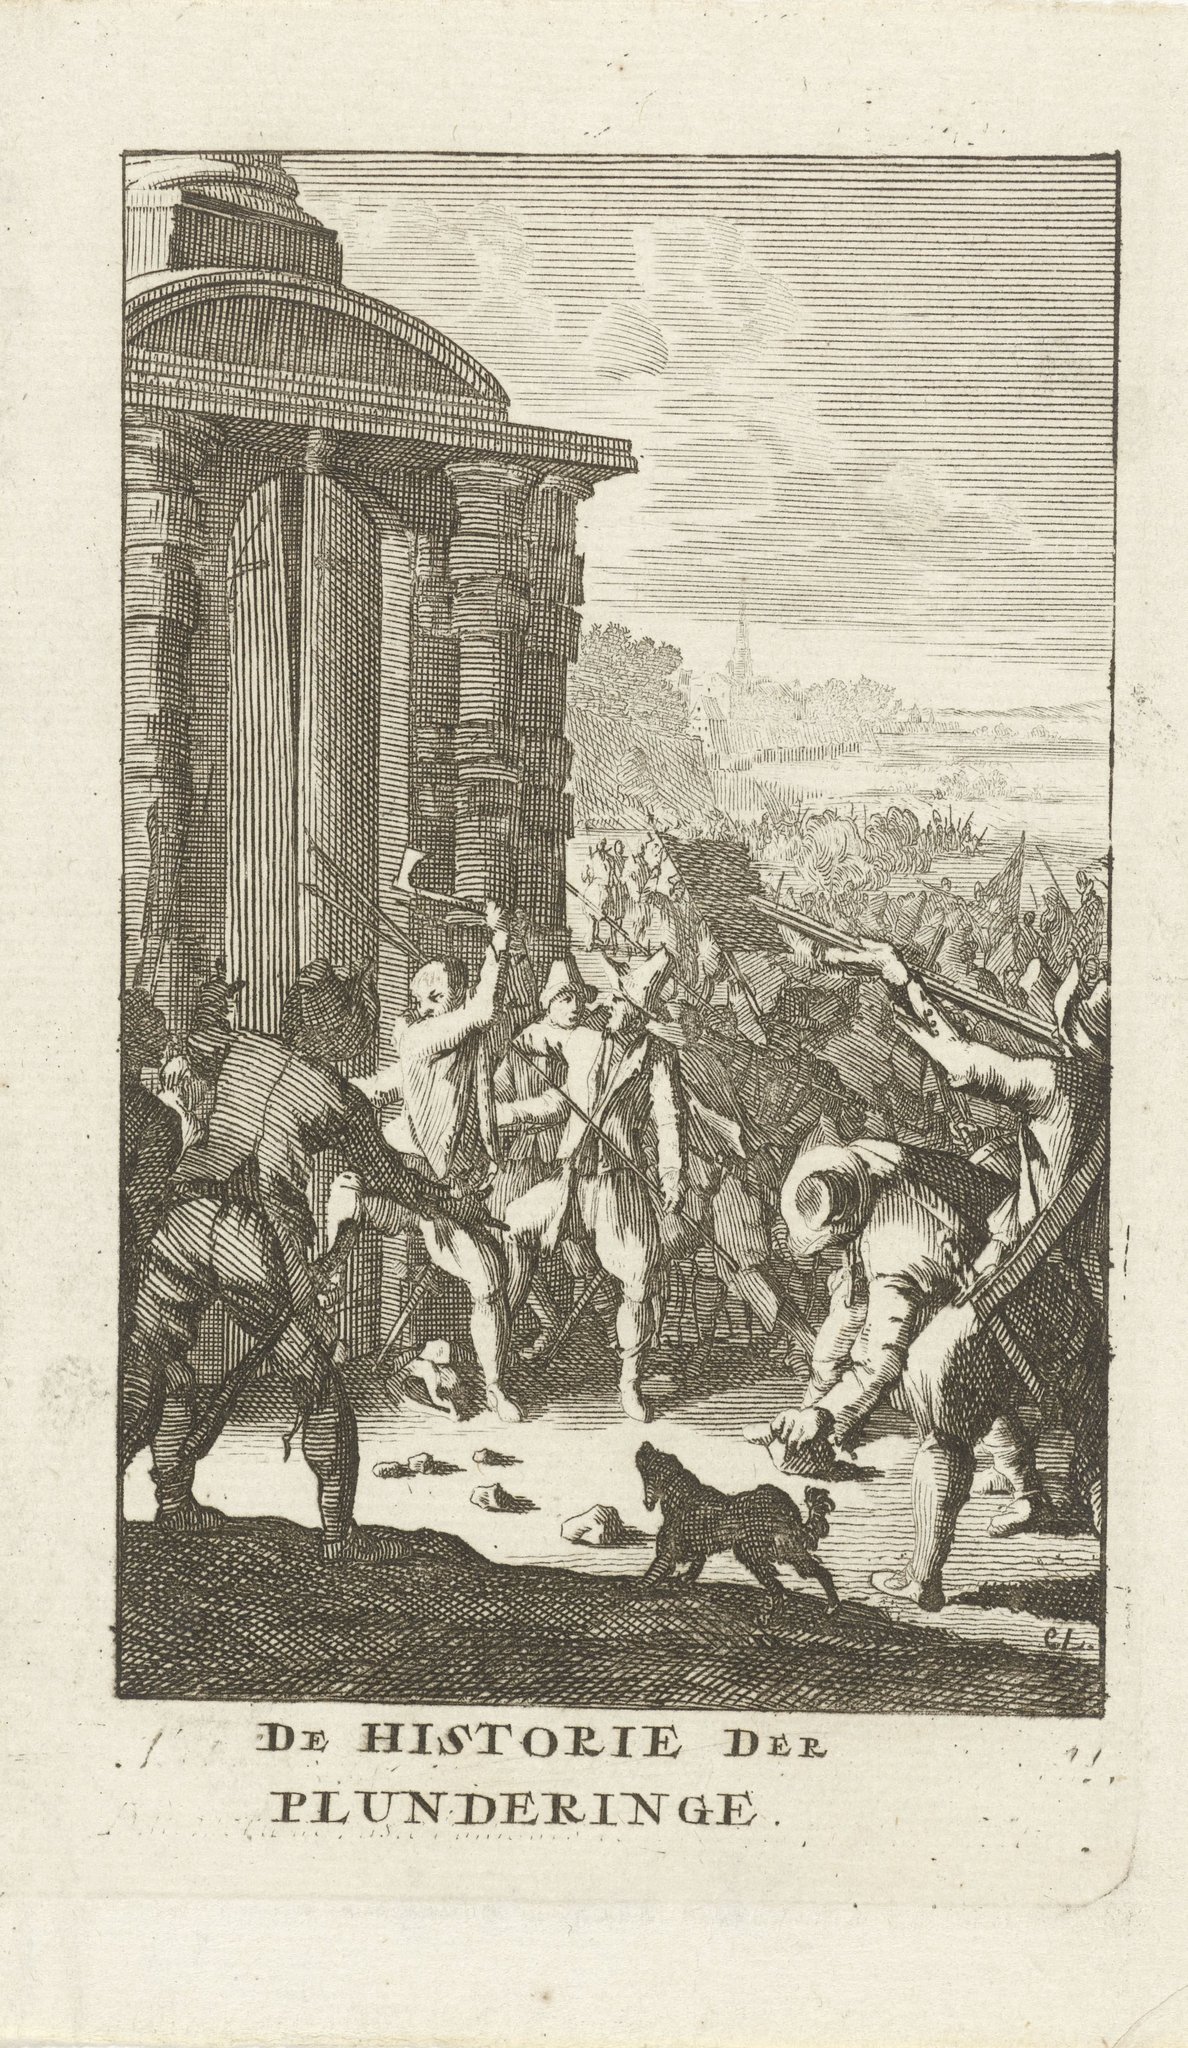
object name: print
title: De Historie der Plunderinge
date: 1692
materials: paper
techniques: etching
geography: leiden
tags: mayor, street-fights, riots, city-gate, middelburg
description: Illustratie uit: Luyken, Casper. Kort dog zakelyk verhaal van alle de plunderingen en verwoestingen van de huizen en goederen der pagters in de provintien van Groningen, Vriesland en Utrecht. Leiden: Wed. Jan van der Deyster, 1748. Eerdere staat gebruikt in: Beronicius, Petrus Johannes. Boeren- en overheidsstrĳd. Amsterdam: Jan Claesz ten Hoorn, 1692.